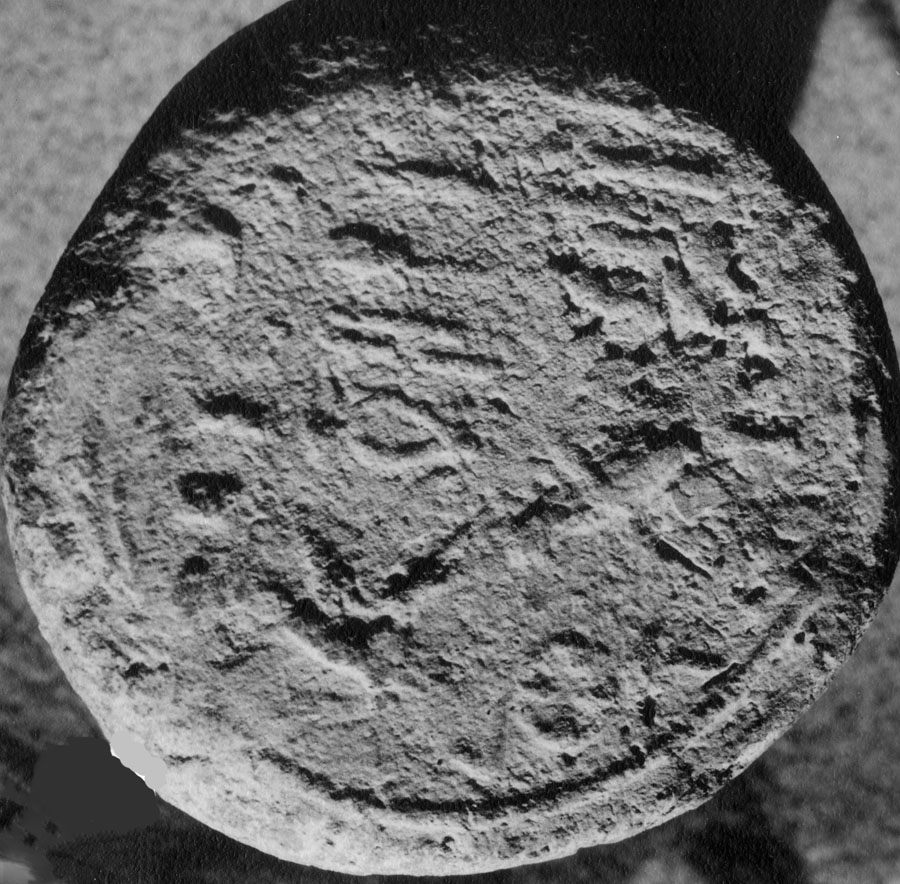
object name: cone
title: Funerary Cone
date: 1550-1295 BCE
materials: pottery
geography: egypt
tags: hieroglyphs